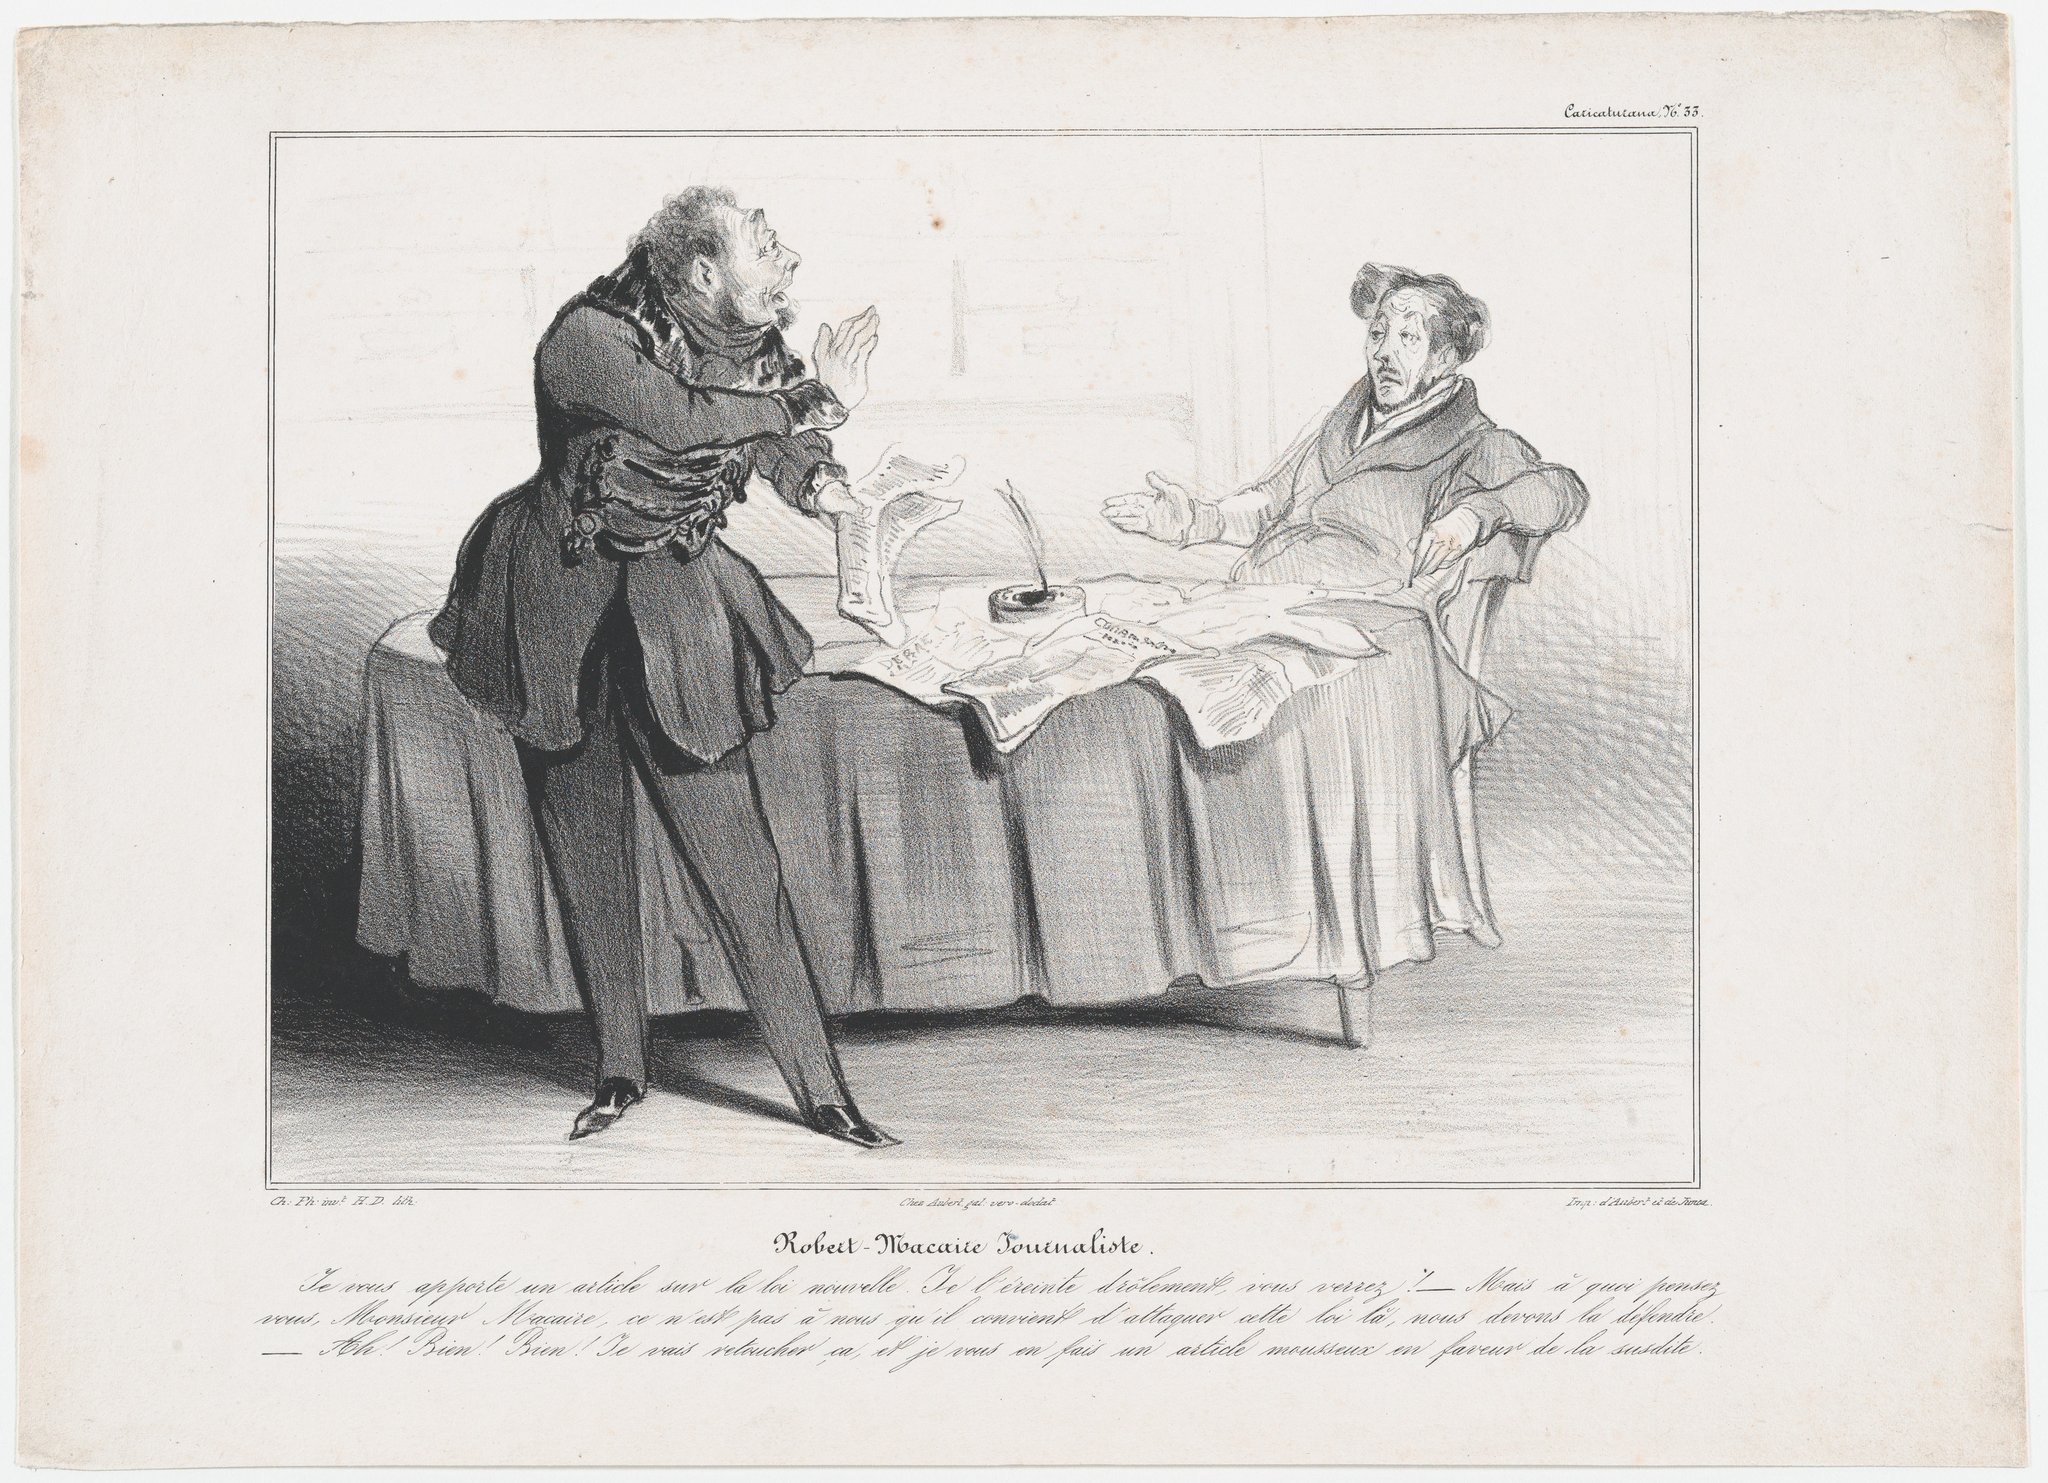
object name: print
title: Plate 33: Robert Macaire journalist, from 'Caricaturana,' published in Les Robert Macaires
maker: honoré daumier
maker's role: artist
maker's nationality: french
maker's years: 1808-1879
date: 1838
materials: paper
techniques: lithograph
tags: men